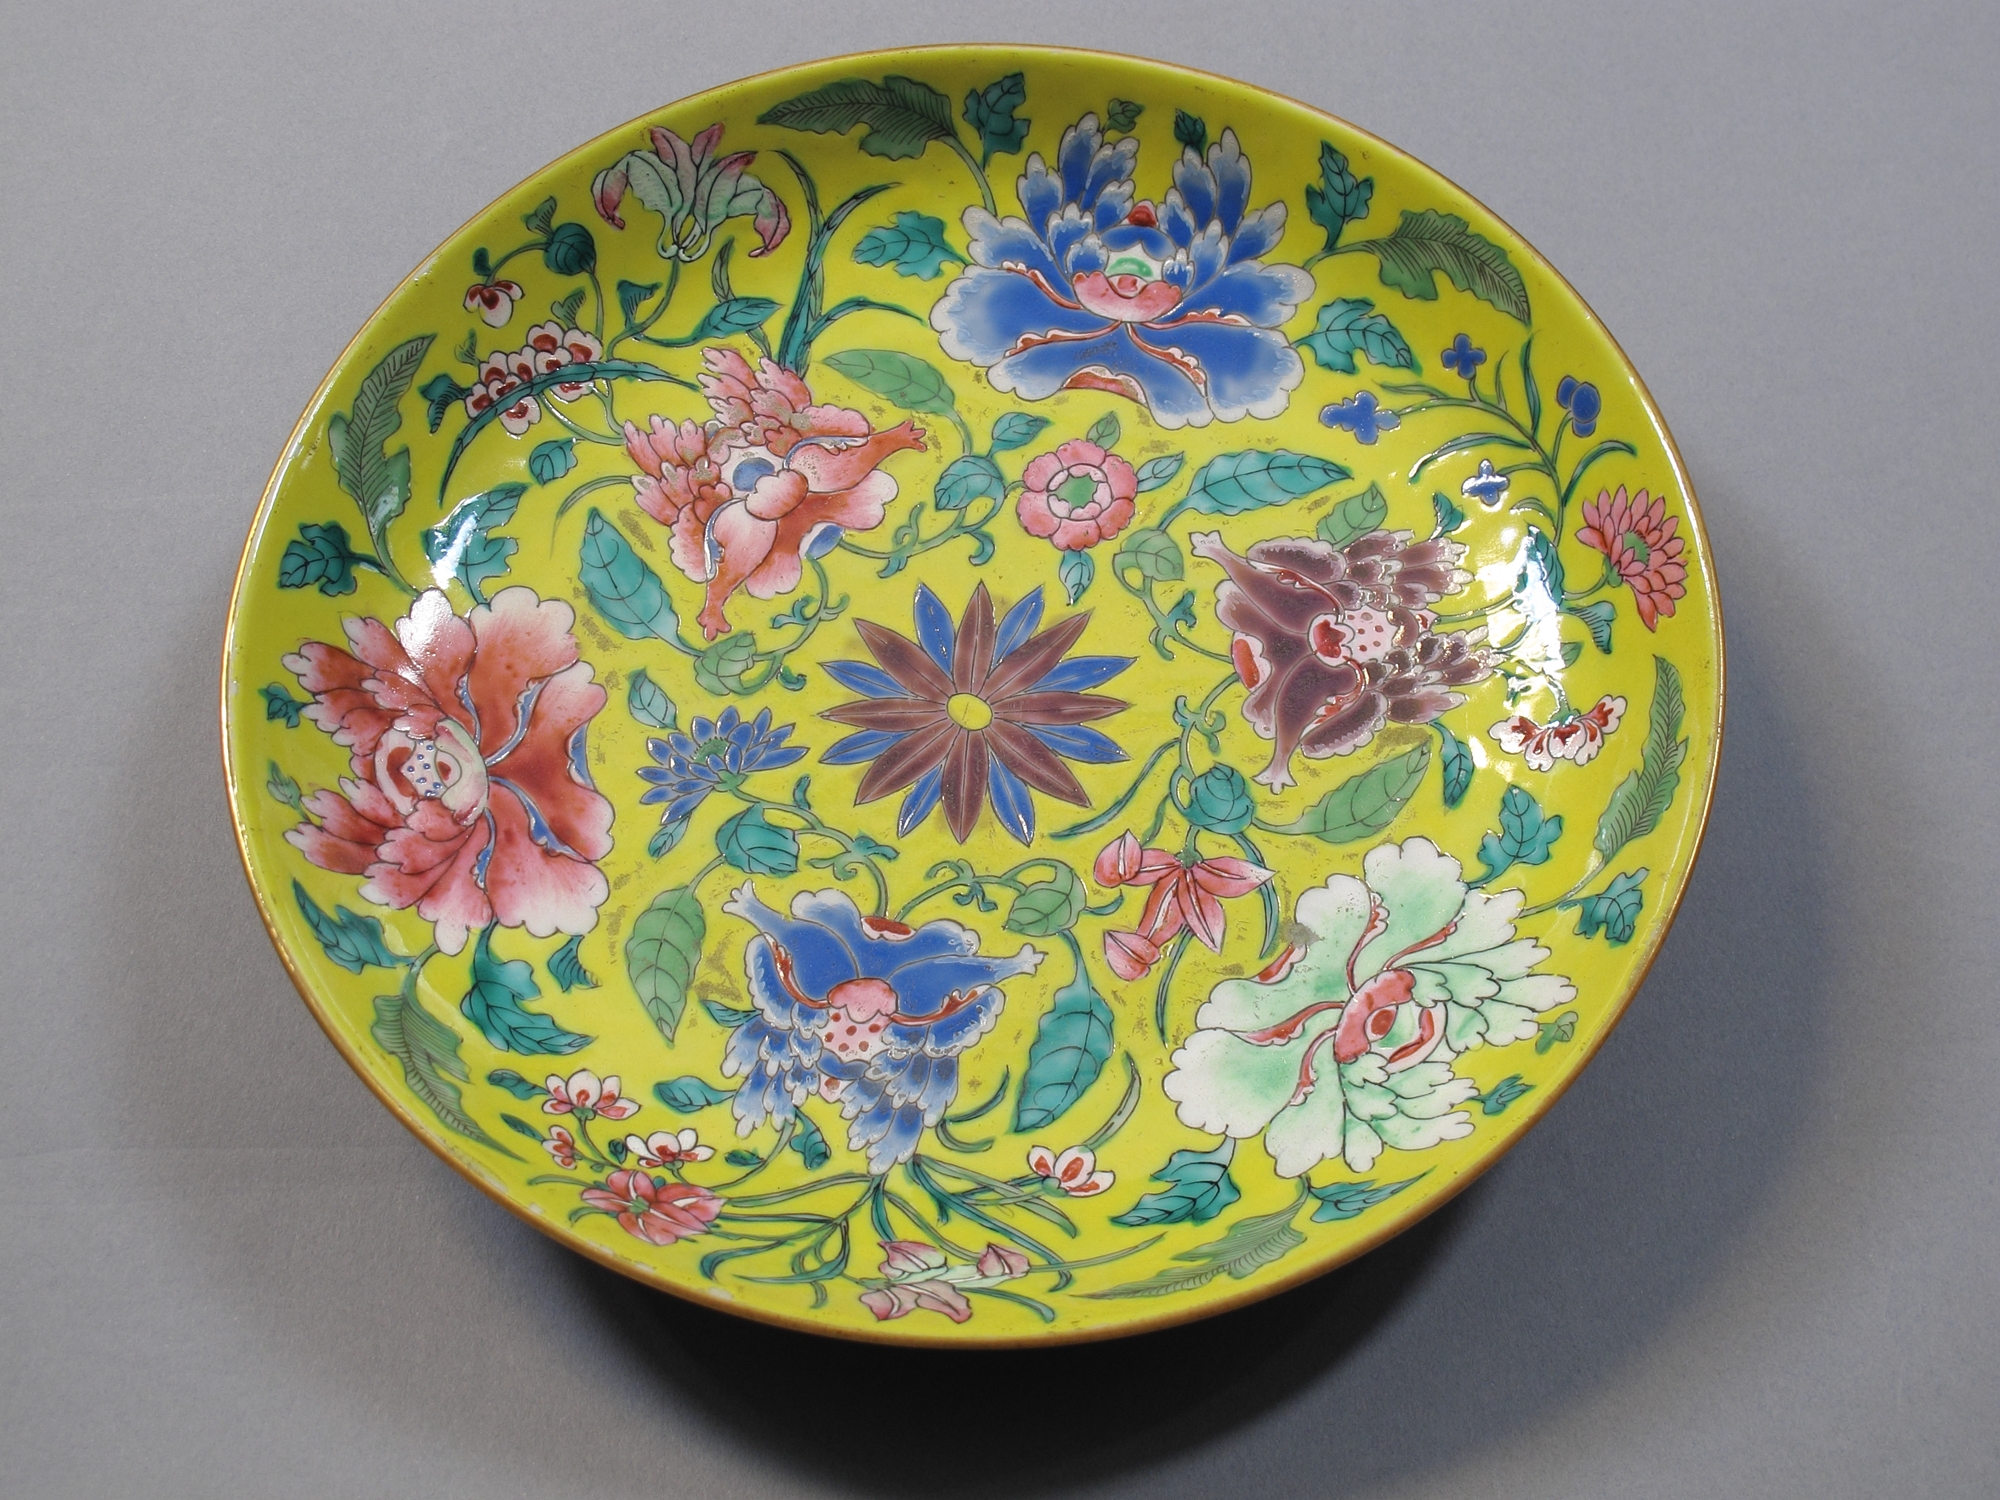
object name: dish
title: Dish with flowers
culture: chinese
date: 1767-1800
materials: enamel, porcelain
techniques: overglaze, painting, polychrome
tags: flowers